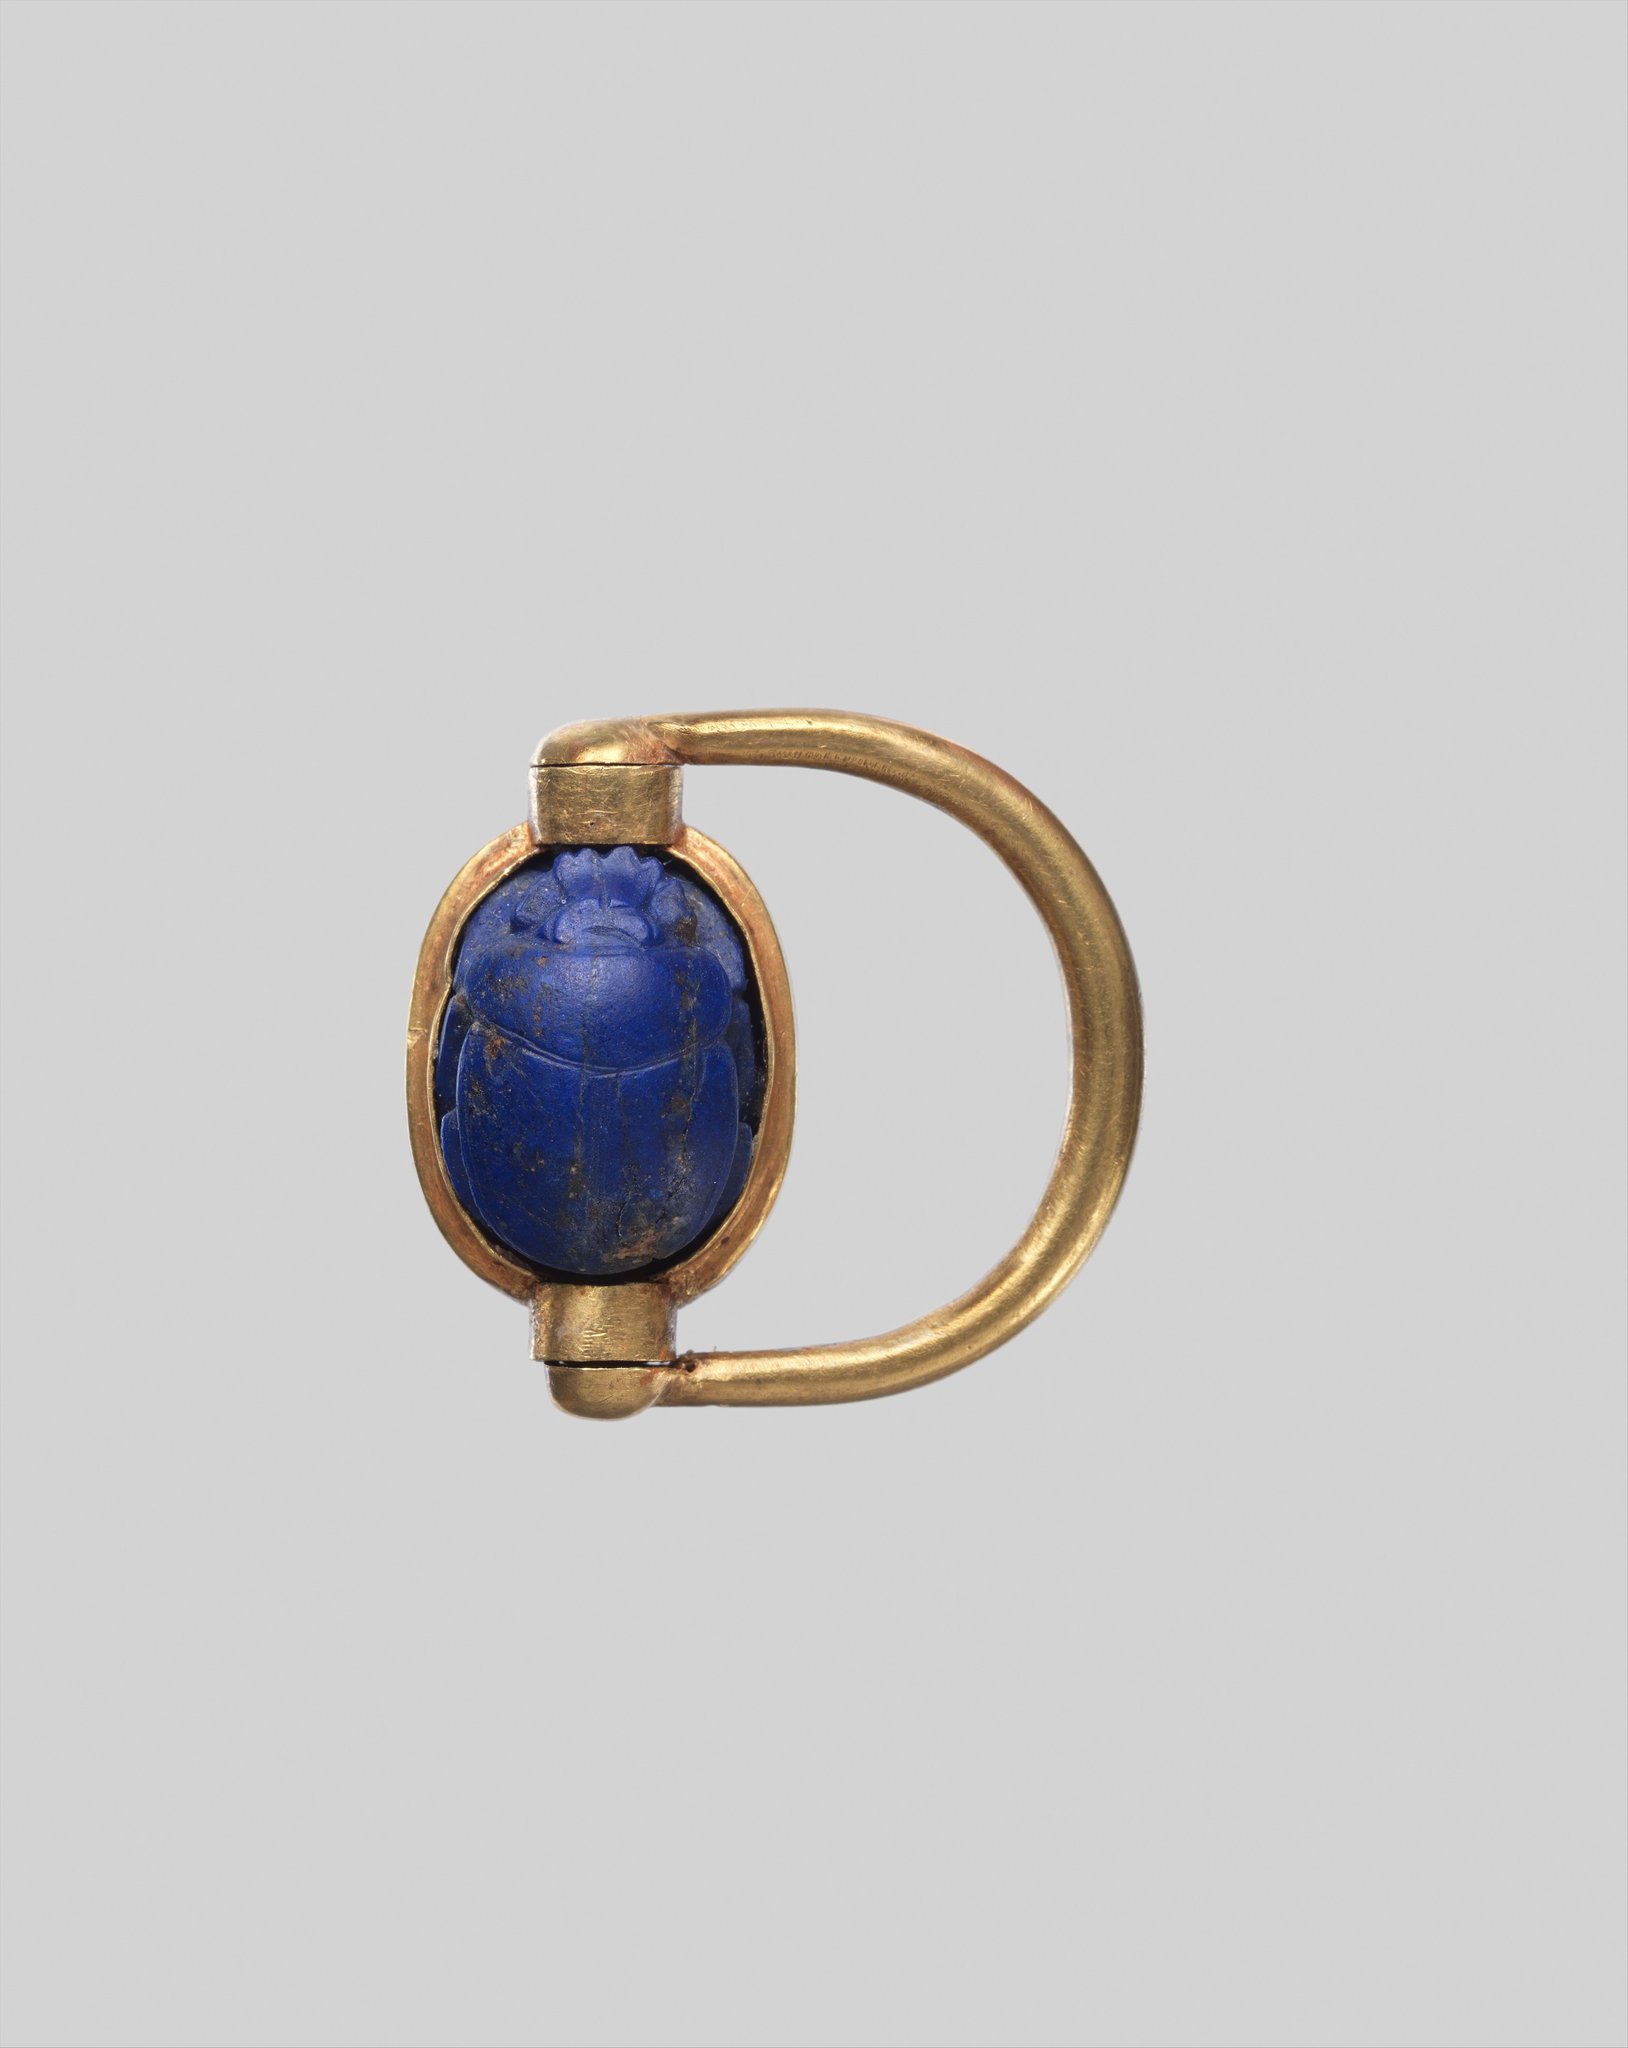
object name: ring, scarab, hatshepsut, thutmose iii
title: Scarab Finger Ring with the Names of Thutmose III and Hatshepsut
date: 1479-1458 BCE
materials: gold, lapis lazuli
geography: egypt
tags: scarabs